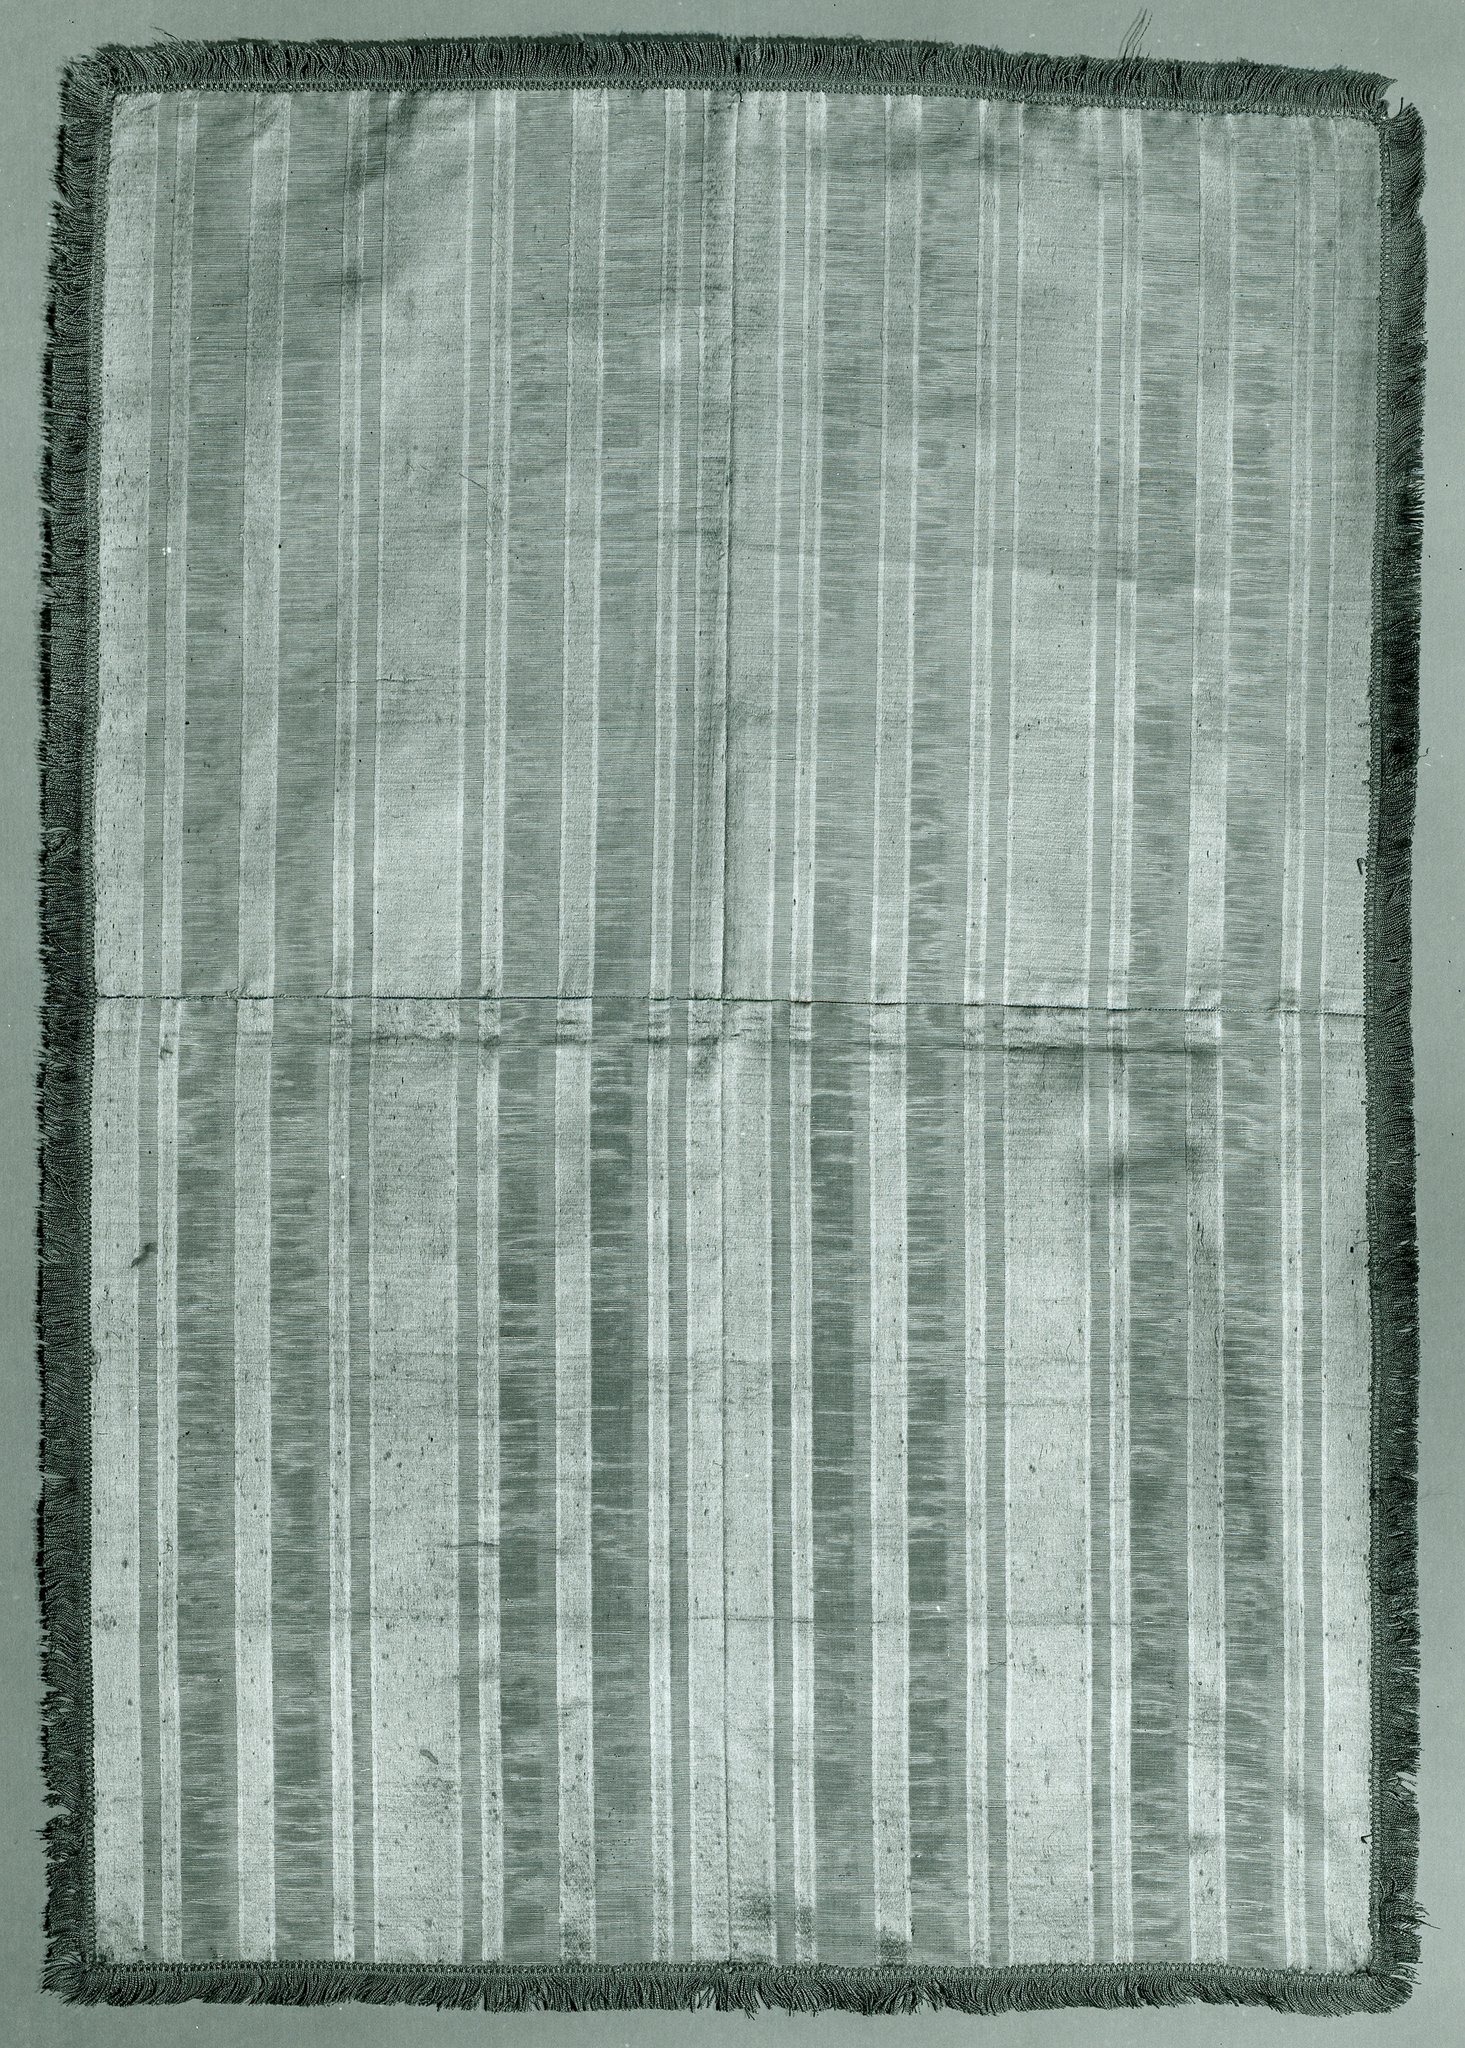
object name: textile panel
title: Panel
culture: french or italian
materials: silk